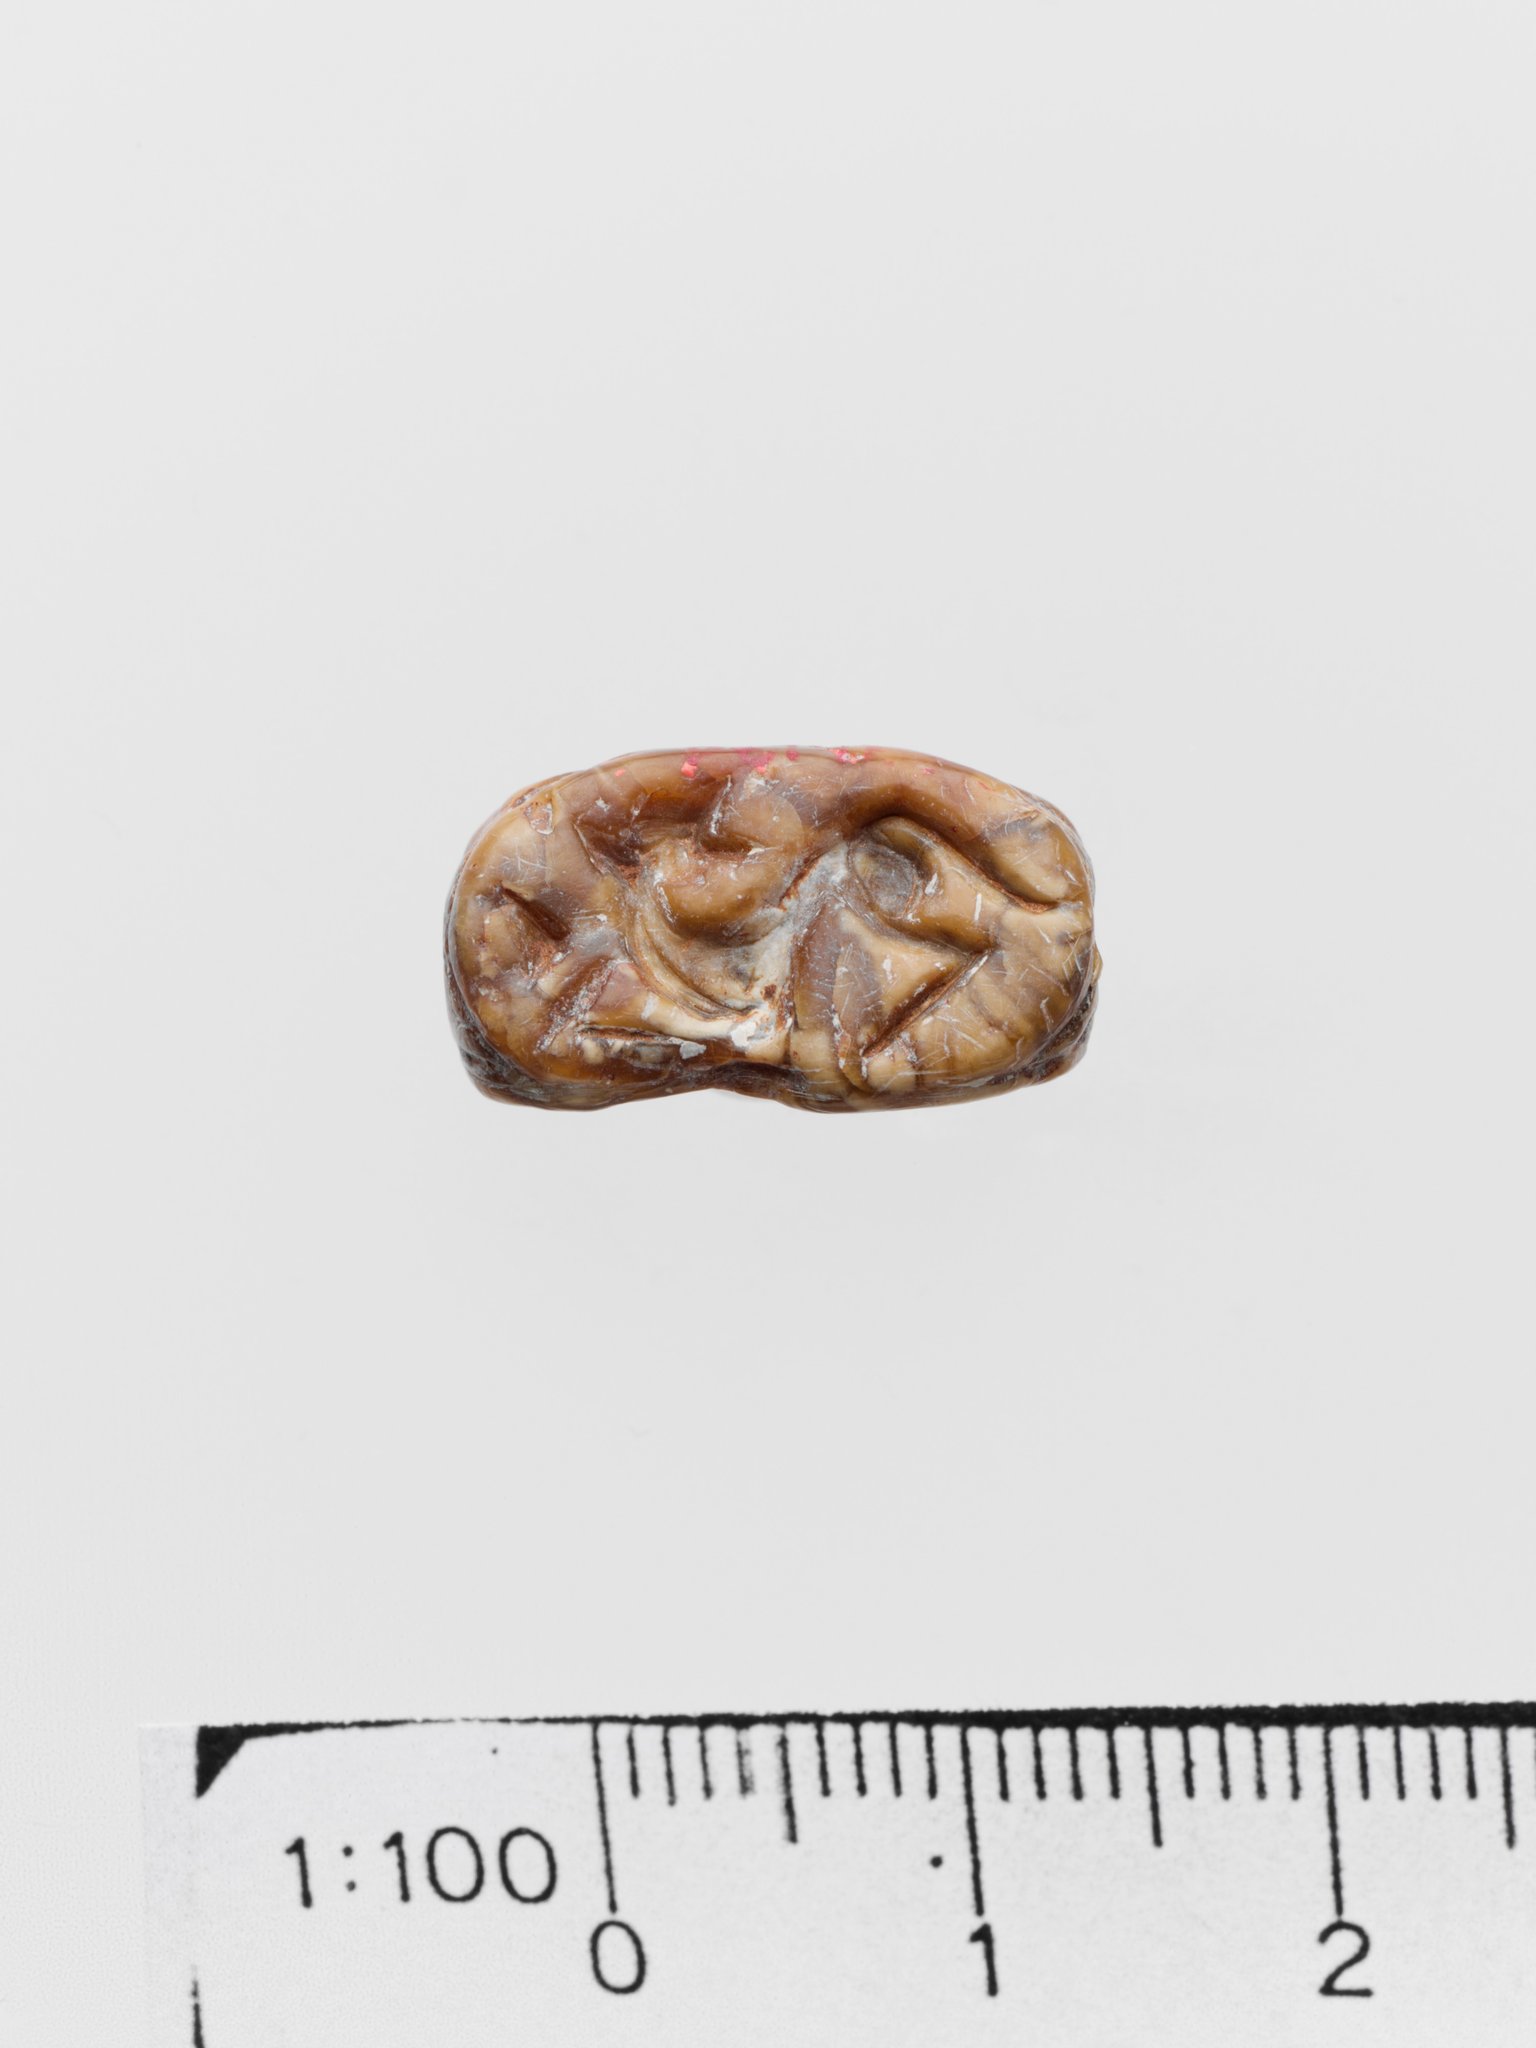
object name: seal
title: Steatite triangular prism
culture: minoan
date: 1900-1750 BCE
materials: stone